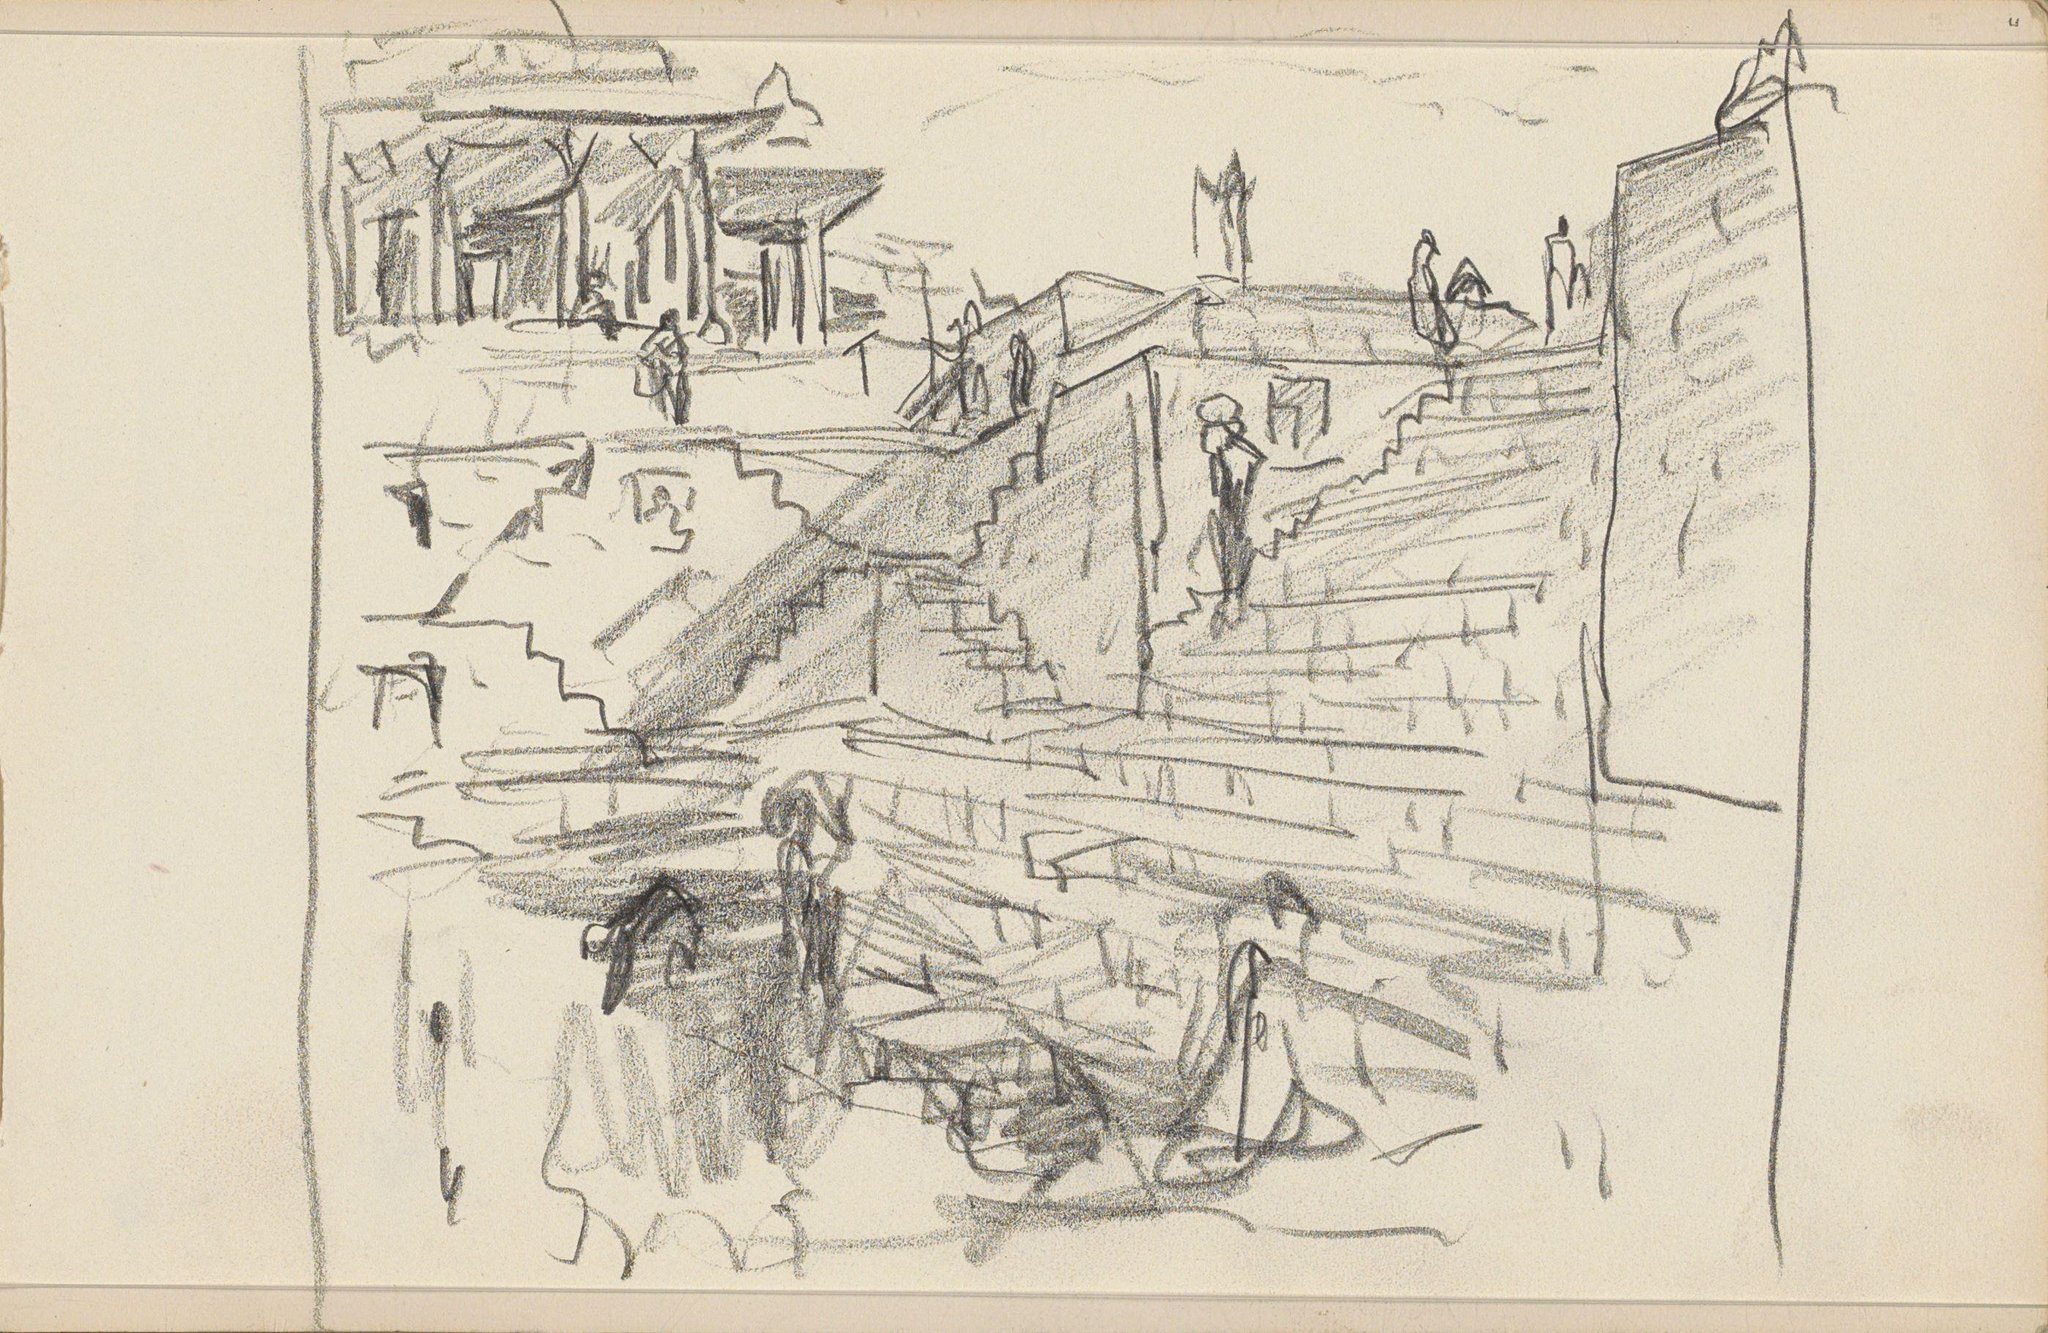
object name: sketchbook leaf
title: Figuren op een stelsel van trappen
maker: marius bauer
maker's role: draughtsman, print maker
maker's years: 1867-1932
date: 1924-1925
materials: paper, pencil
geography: india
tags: temple, shrine ~ hinduism, buddhism, jainism, flight of steps, walking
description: De trappen leiden naar een gebouw, vermoedelijk een tempel. Pagina 11 uit een schetsboek met 48 bladen.